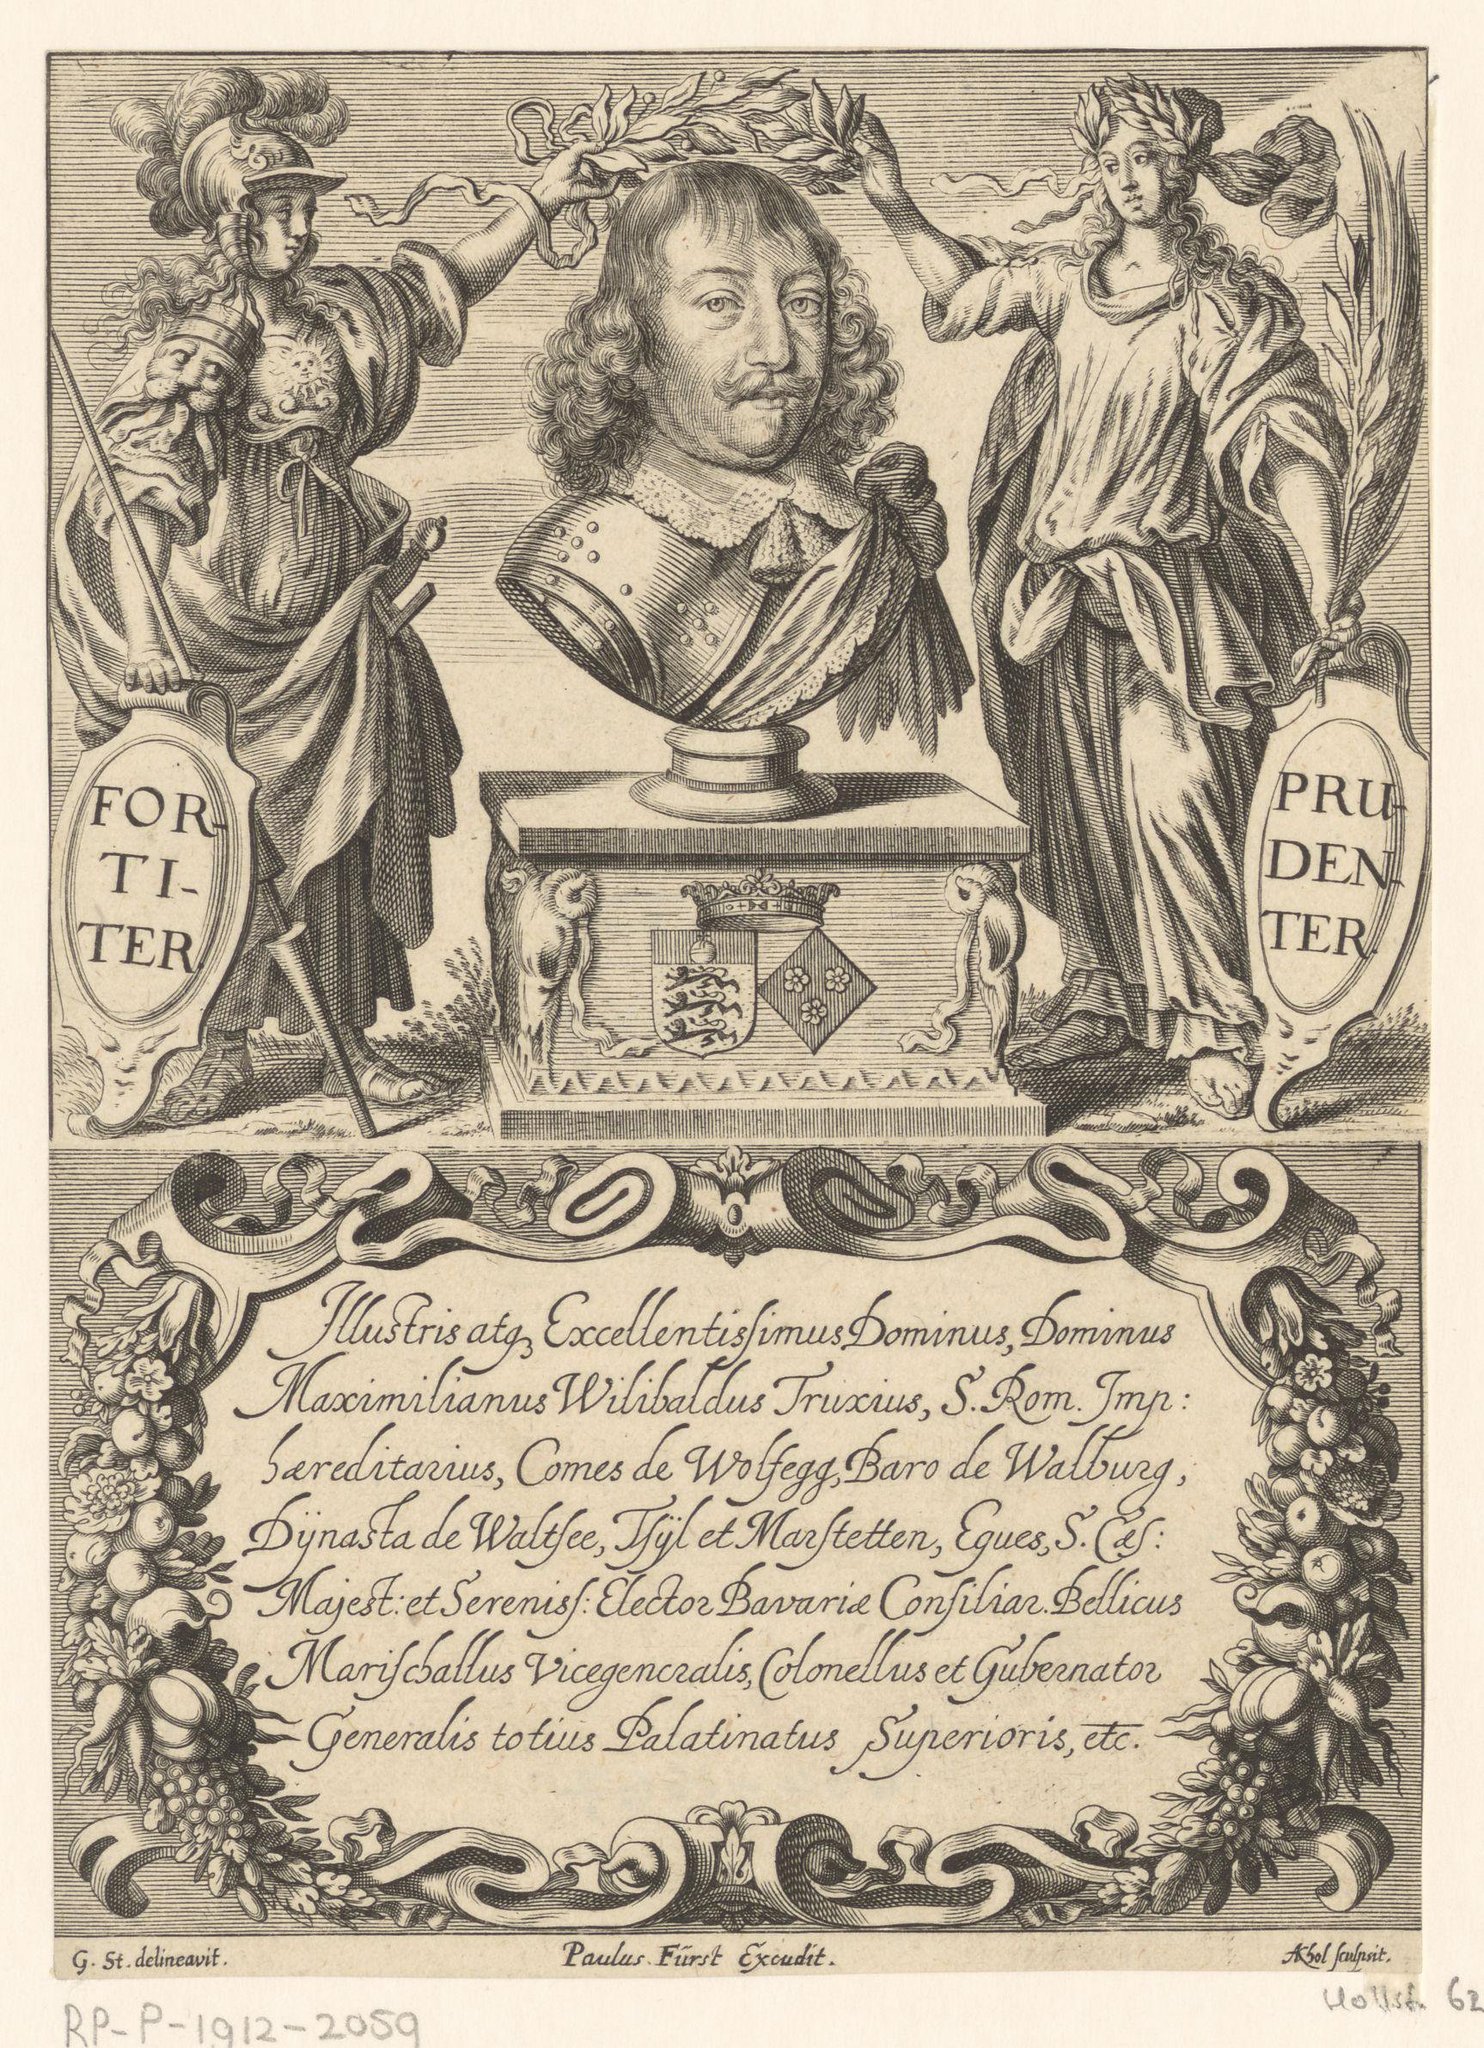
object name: print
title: Portret van Maximilian Wilibald von Waldburg-Wolfegg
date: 1634-1657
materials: paper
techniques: engraving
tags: amberg, earl, maximilian willibald von waldburg-wolfegg (graaf), fortitude, 'fortitudo' ~ one of the four cardinal virtues, prudence, 'prudentia'; 'prudenza' (ripa) ~ one of the four cardinal virtues, historical persons, diplomacy, diplomat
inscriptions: collector's mark: Lugt 2228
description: Aan weerszijden van de sokkel met het borstbeeld twee personificaties van de kardinale deugden moed en wijsheid. Tekst in het Latijn in de cartouche.